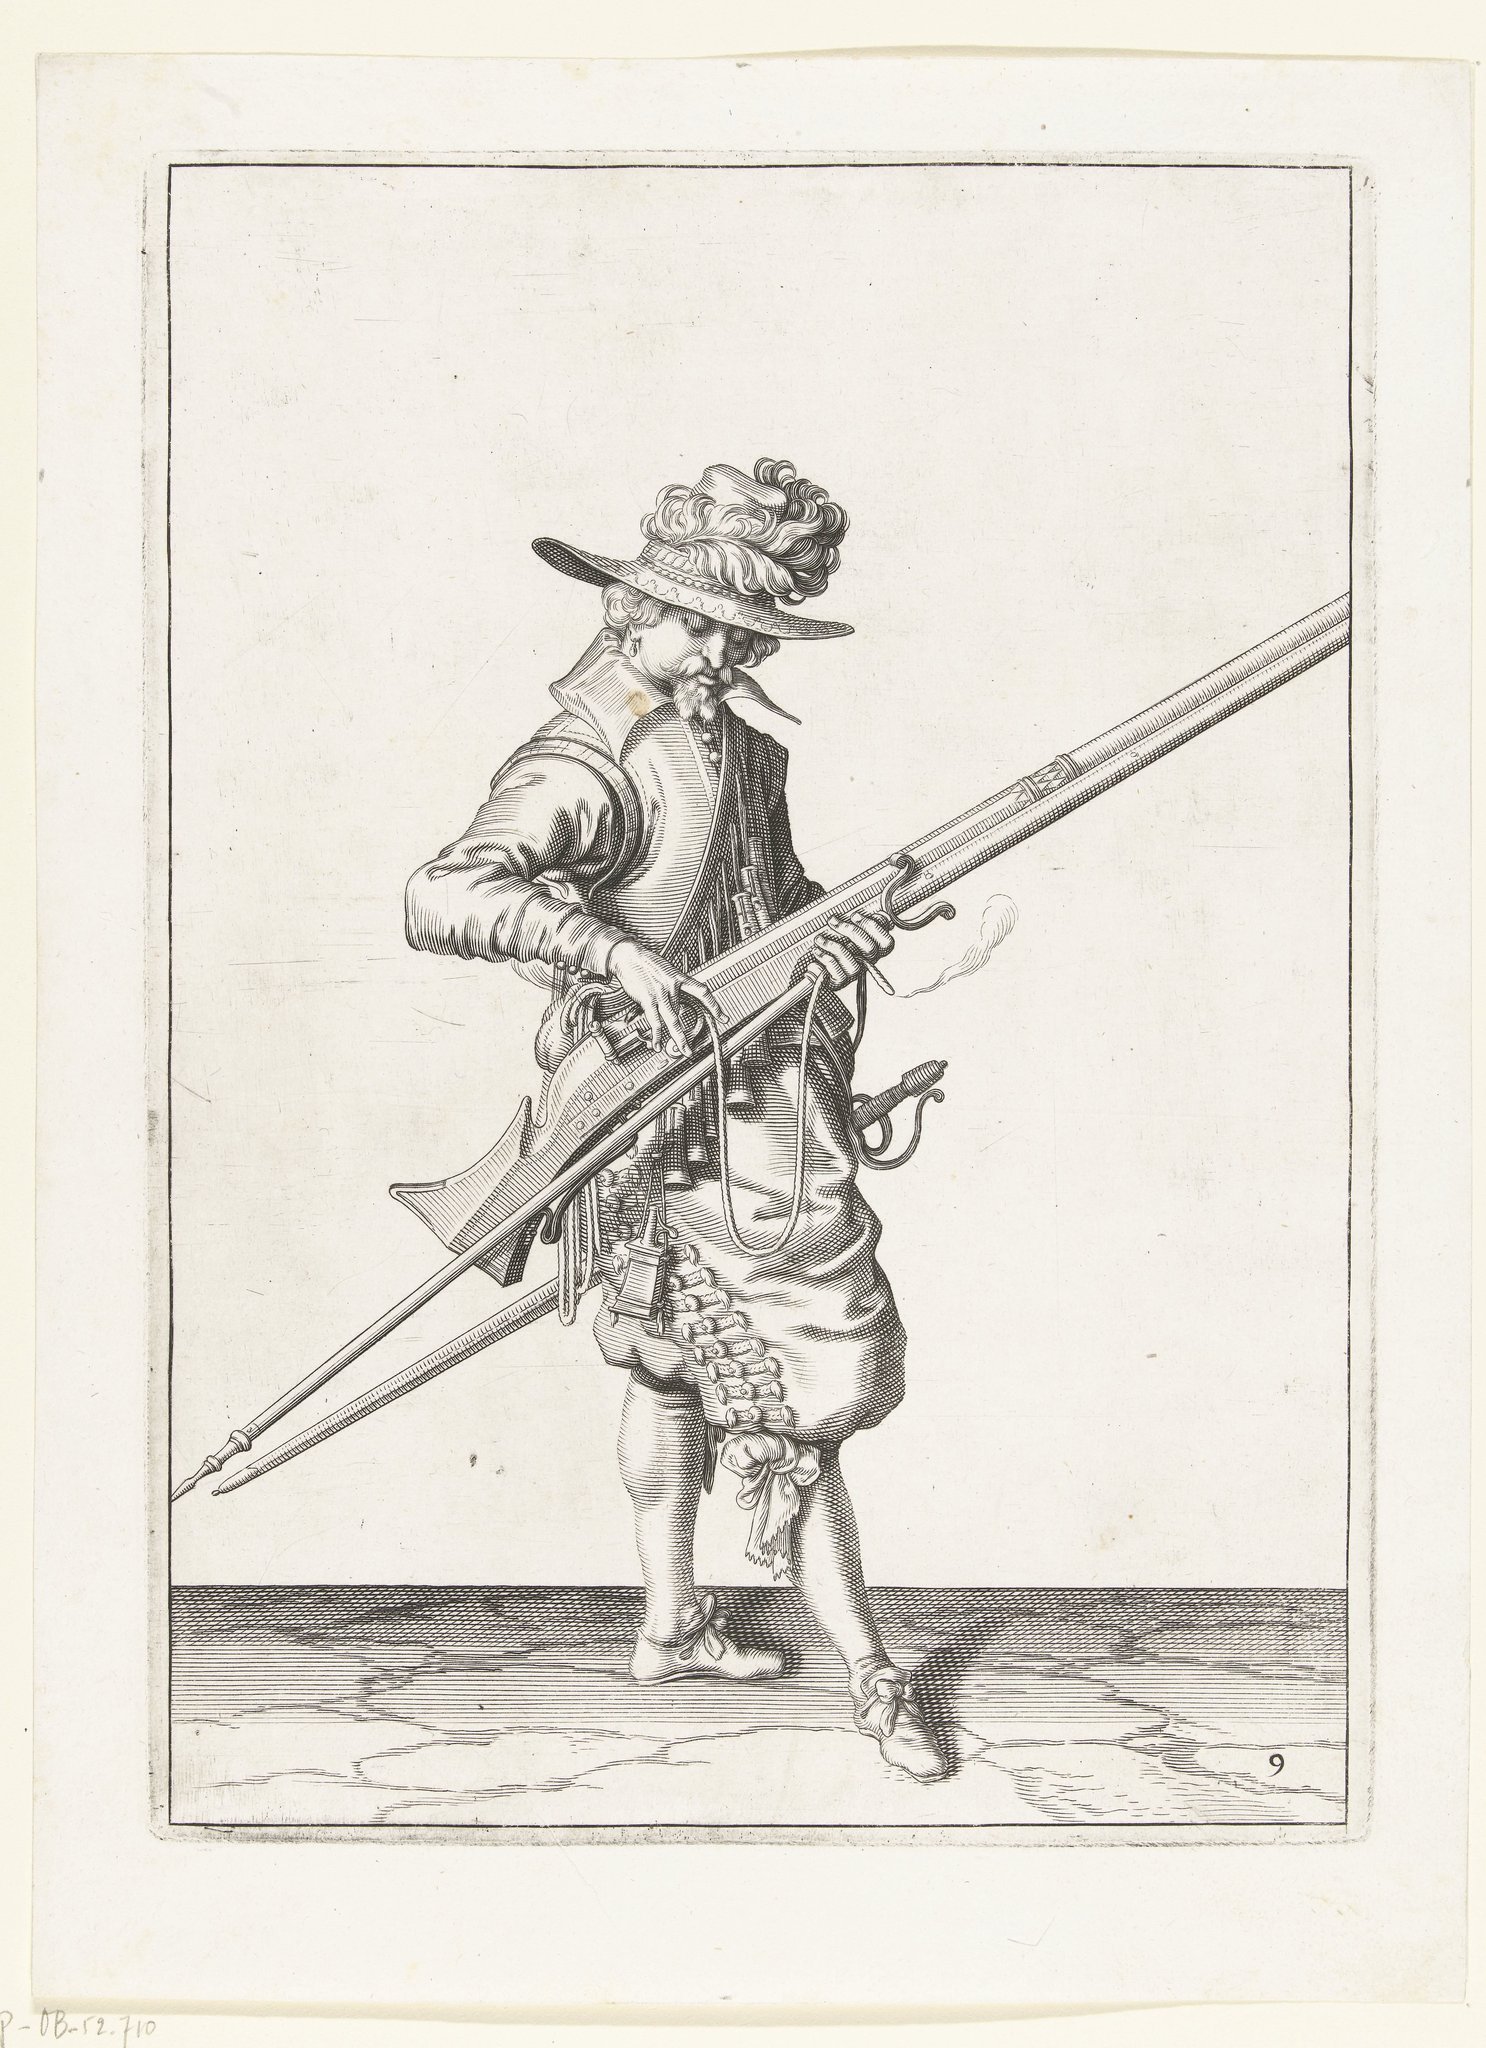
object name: print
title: Wapenhandelinghe van Roers Musquetten ende Spiessen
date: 1597-1607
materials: paper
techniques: engraving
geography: netherlands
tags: manoeuvre ~ military training, firearms: rifle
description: Een soldaat, ten voeten uit, naar rechts, die een musket (een bepaald type vuurwapen) met zijn linkerhand vasthoudt. Met duim en middelvinger van zijn rechterhand geeft hij de brandende lont op de haan (onderdeel van het ontstekingsmechanisme) van zijn musket de juiste plek en vorm. Deze prent is onderdeel van de reeks van 43 genummerde prenten van musketiers uit de Wapenhandelinghe.